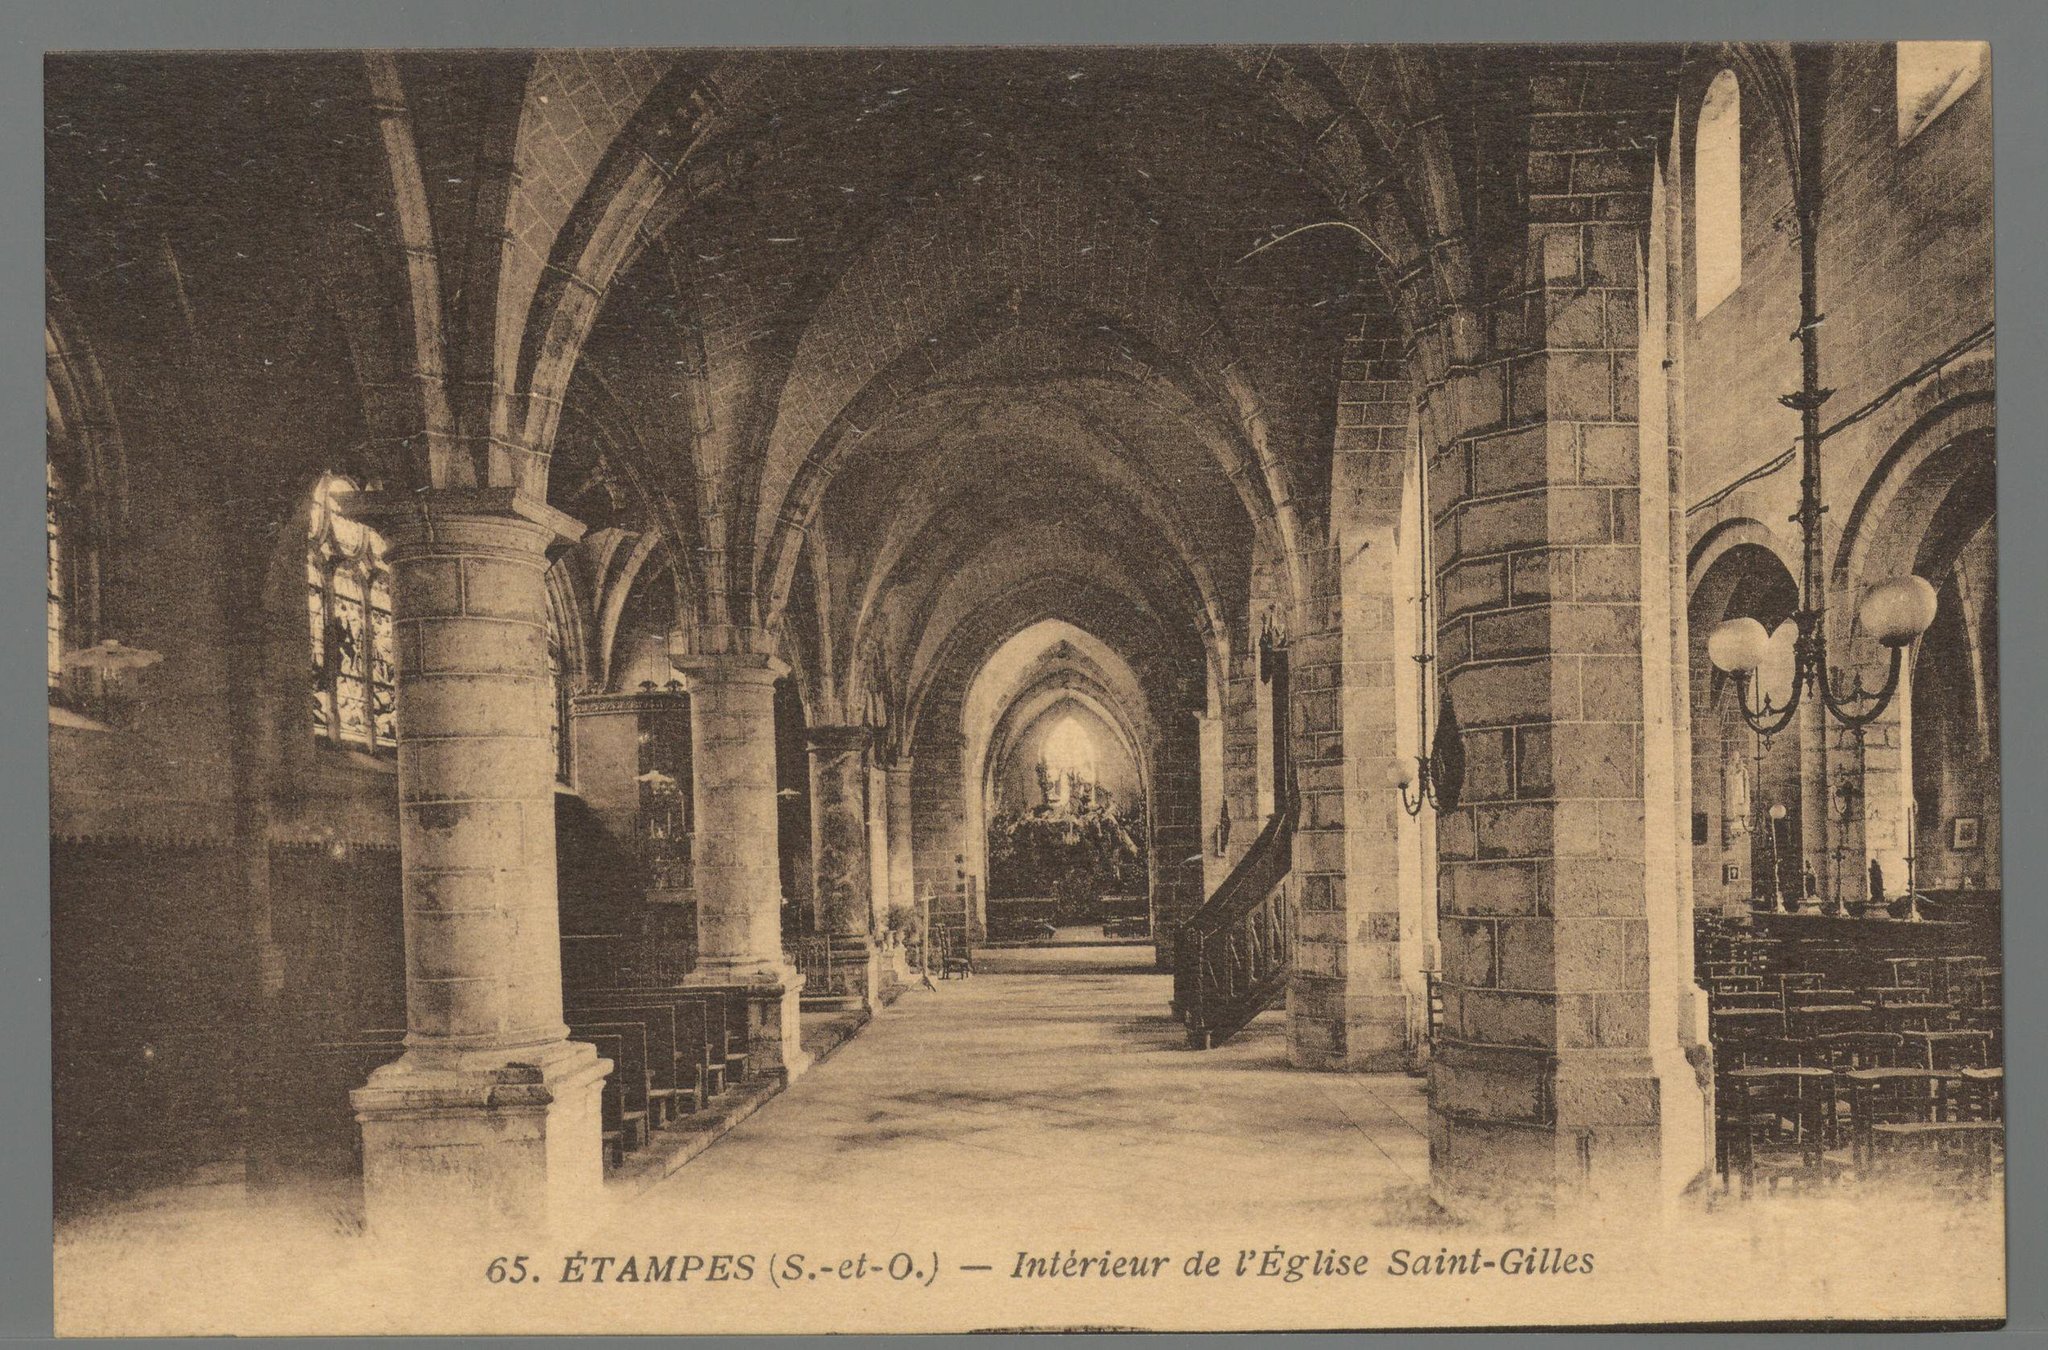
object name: ansichtkaart, prentbriefkaart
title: Étampes (S.-et-O.) - Intérieur de l'Eglise Saint-Gilles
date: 1903-1930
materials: cardboard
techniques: photograph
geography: etampes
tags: interior of church